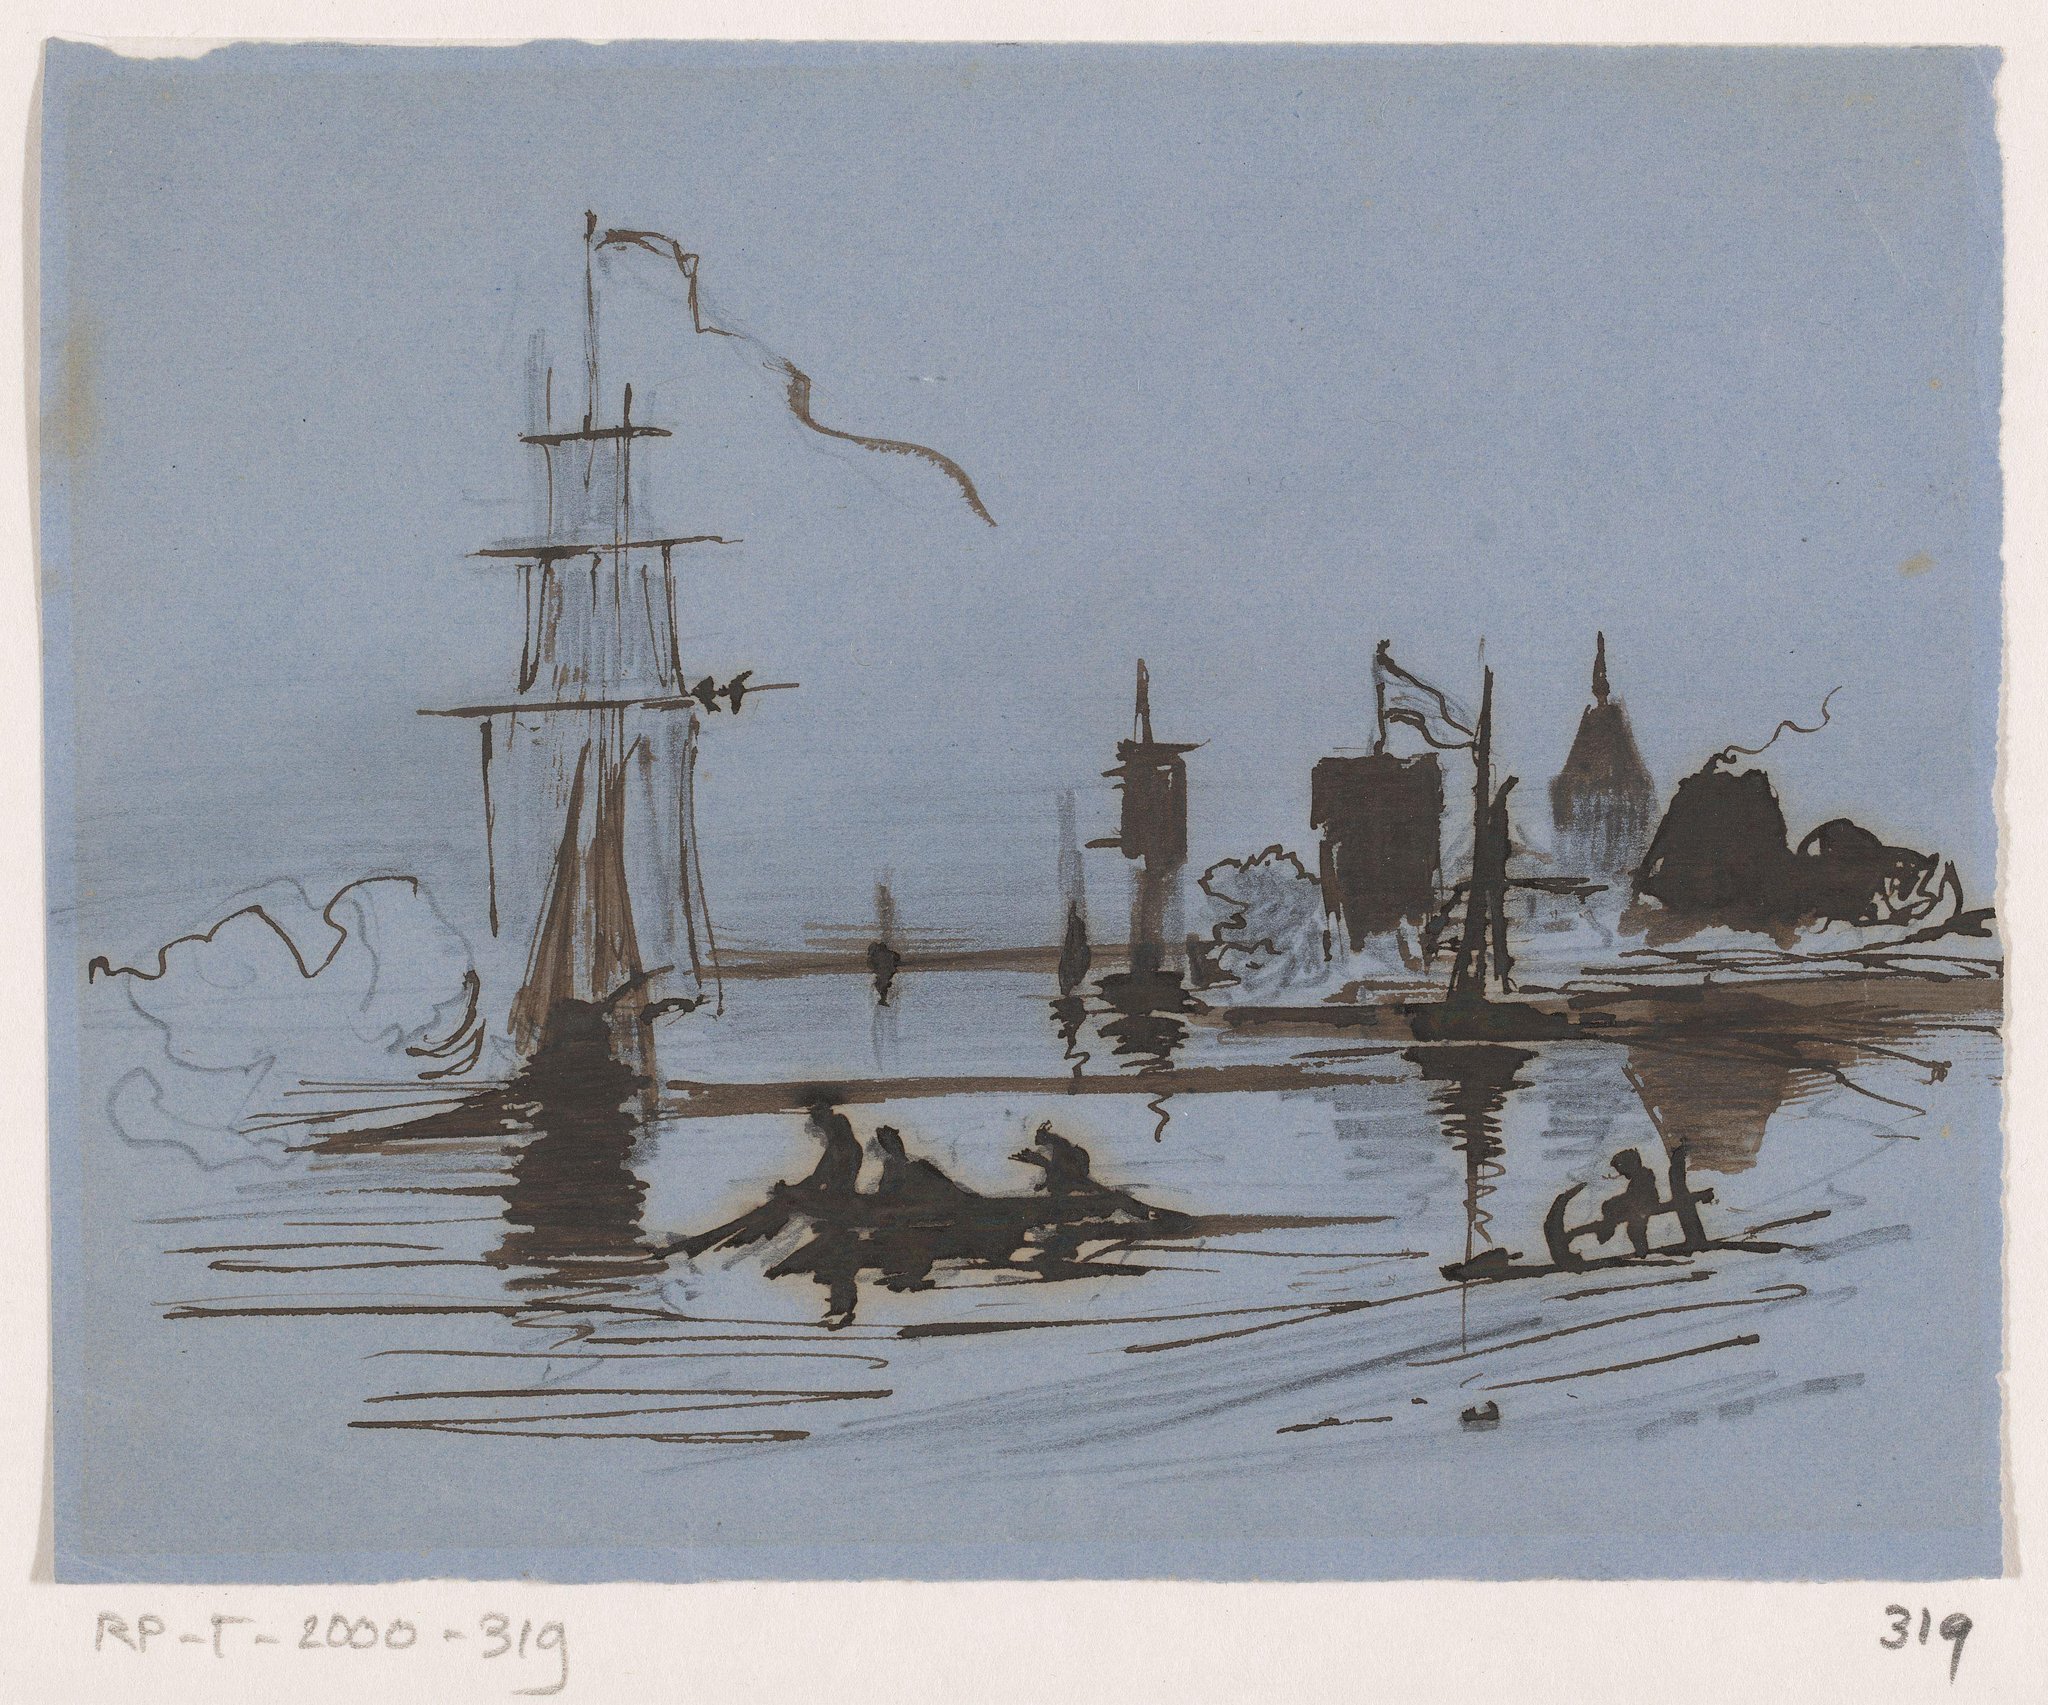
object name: drawing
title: Rivierlandschap met schip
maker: johannes tavenraat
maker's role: draughtsman, painter, print maker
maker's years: 1809-1881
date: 1840-1880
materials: ink, paper, pencil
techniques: brush, pen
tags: sailing-ship, sailing-boat, rowing-boat, canoe, etc., river (+ landscape with figures, staffage)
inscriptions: collector's mark: Lugt 2228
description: Rivierlandschap met een schip dat een kanonschot lost, op de voorgrond een sloep met personen, rechts meer schepen voor een stad.